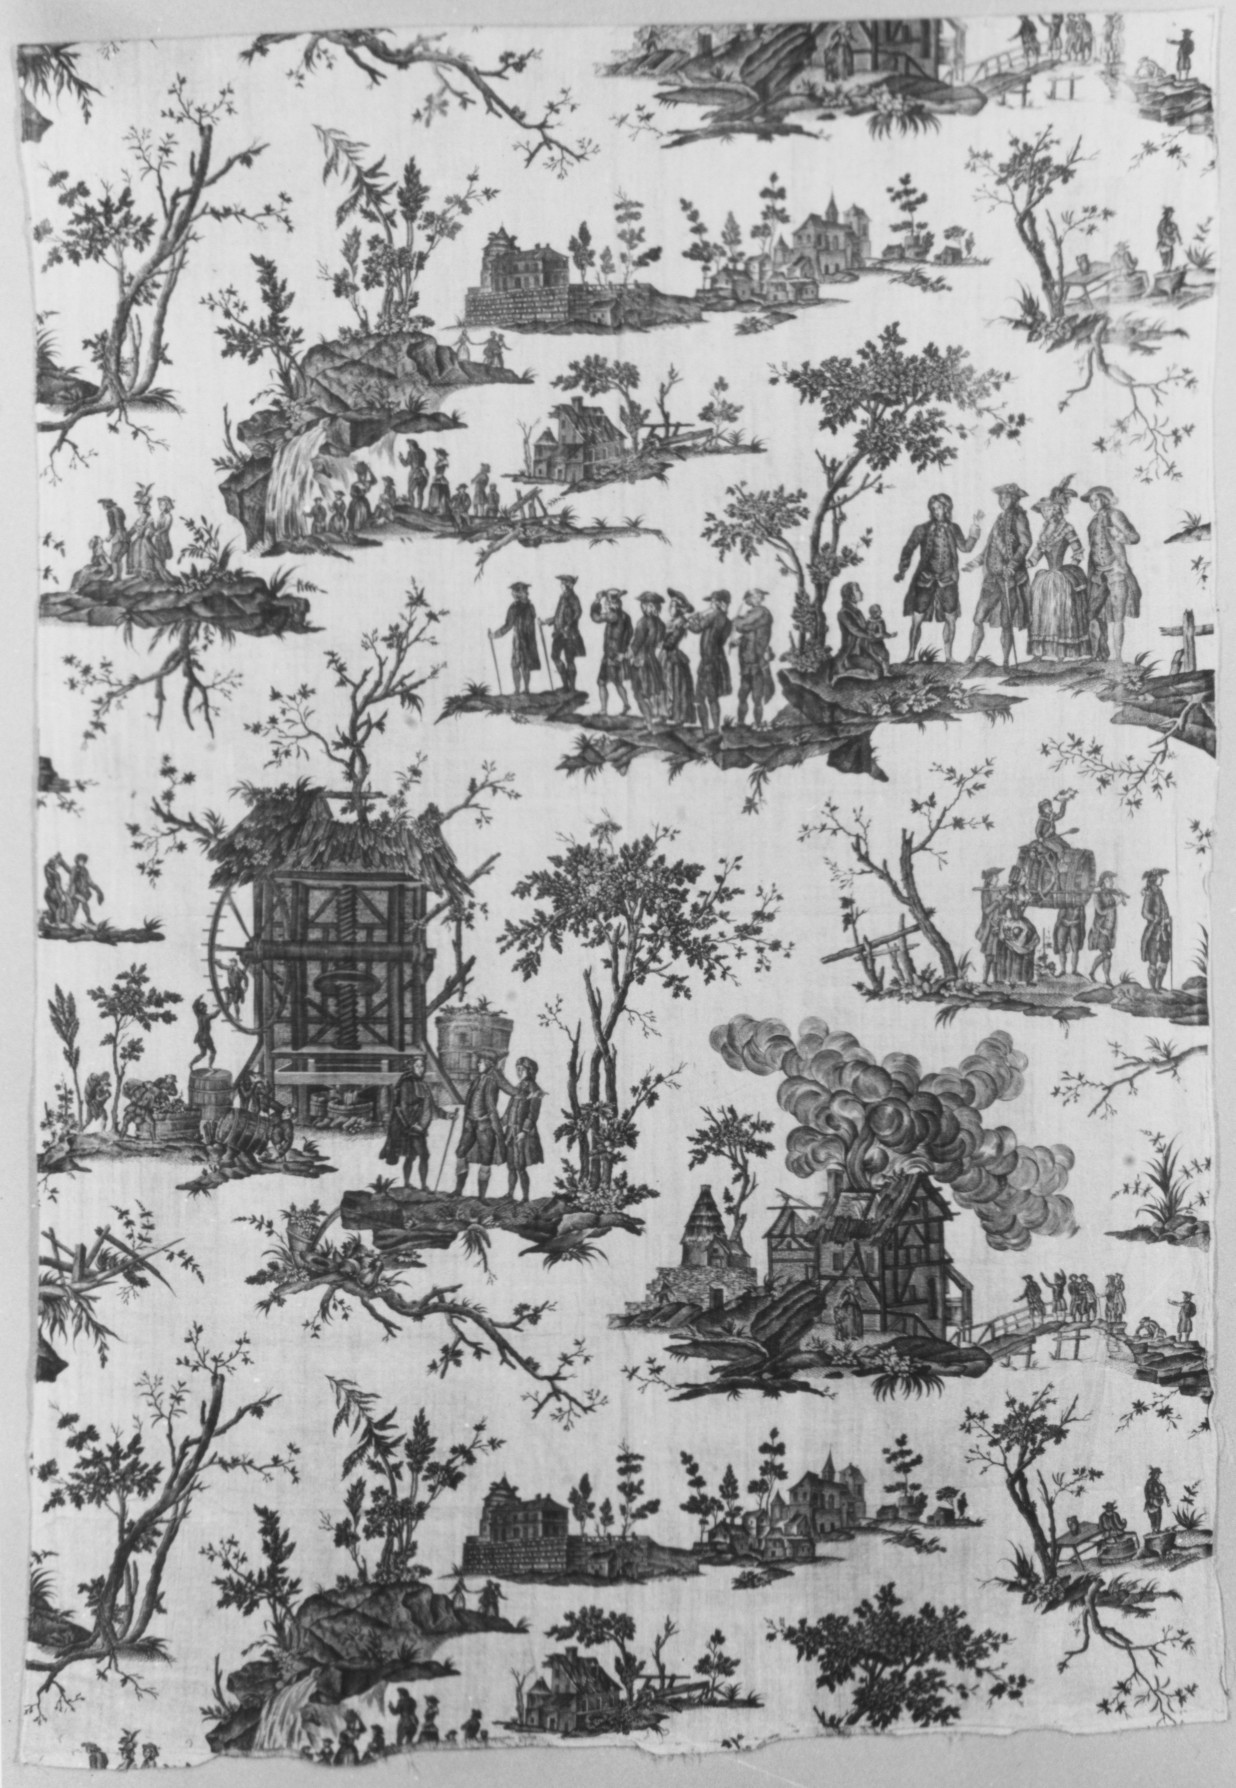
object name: piece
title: "La Maison Brulante"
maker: petitpierre et cie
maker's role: manufactory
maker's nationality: french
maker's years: 1790-1802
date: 1785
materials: cotton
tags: buildings,men,women,fire